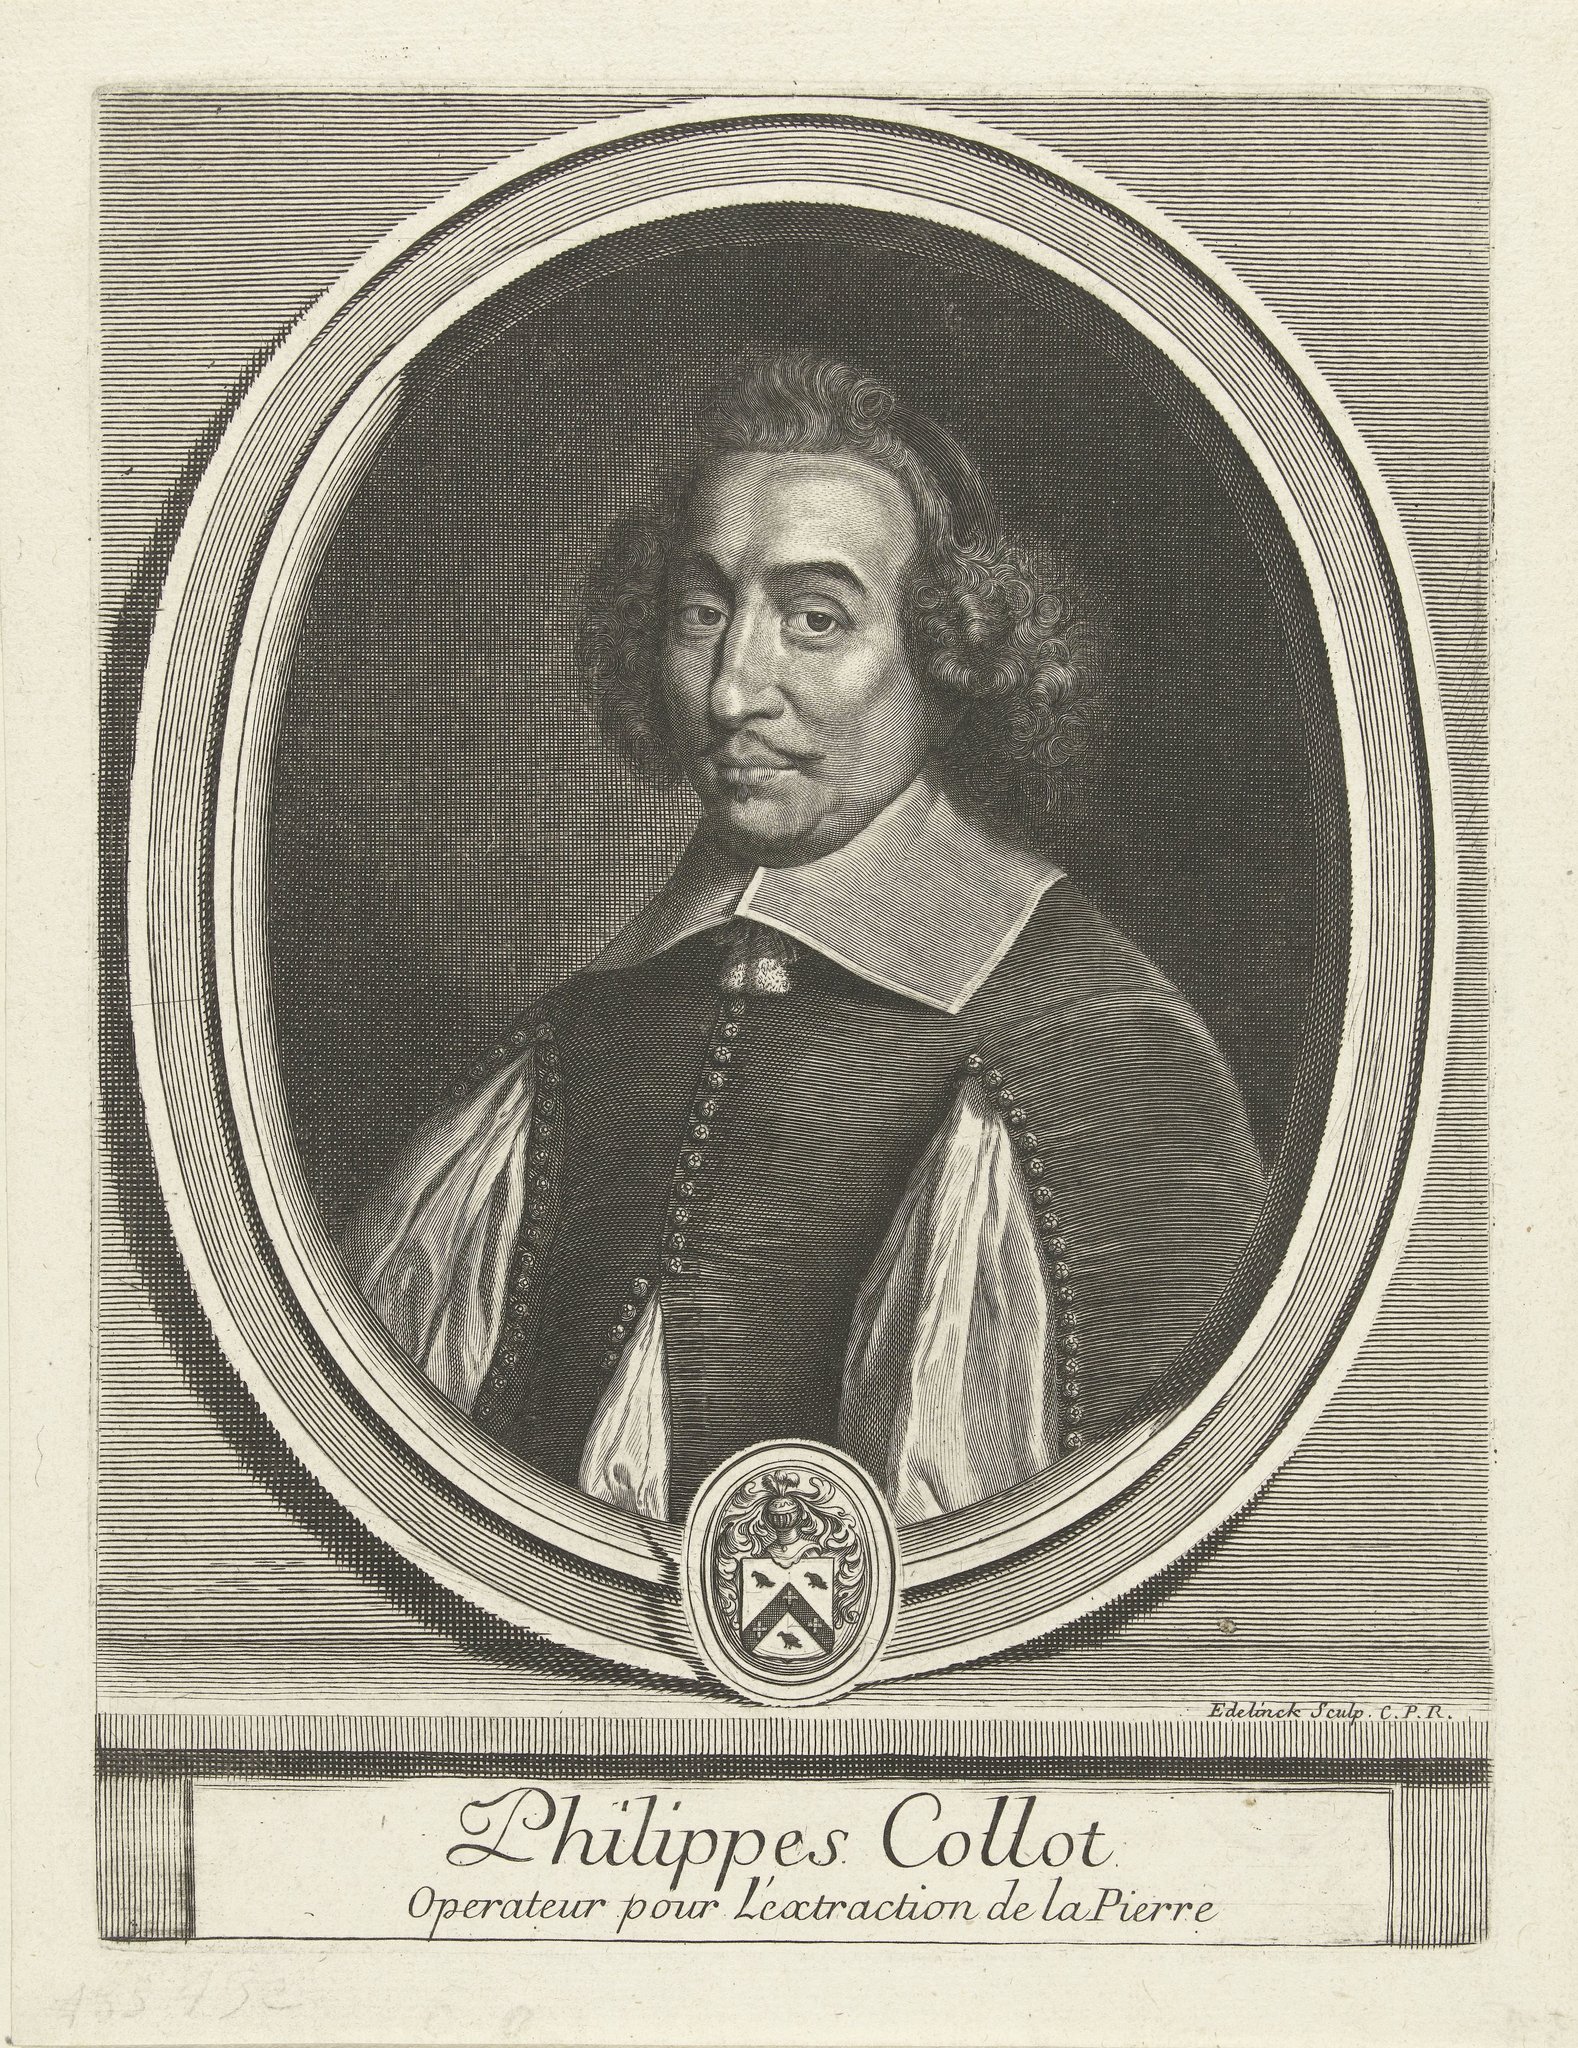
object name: print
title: Philippes Collot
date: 1666-1707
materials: paper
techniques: engraving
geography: france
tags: arts, philippe collot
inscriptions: collector's mark: Lugt 240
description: Busteportret van de arts Philippe Collot, afgebeeld in ovale omlijsting met wapen.